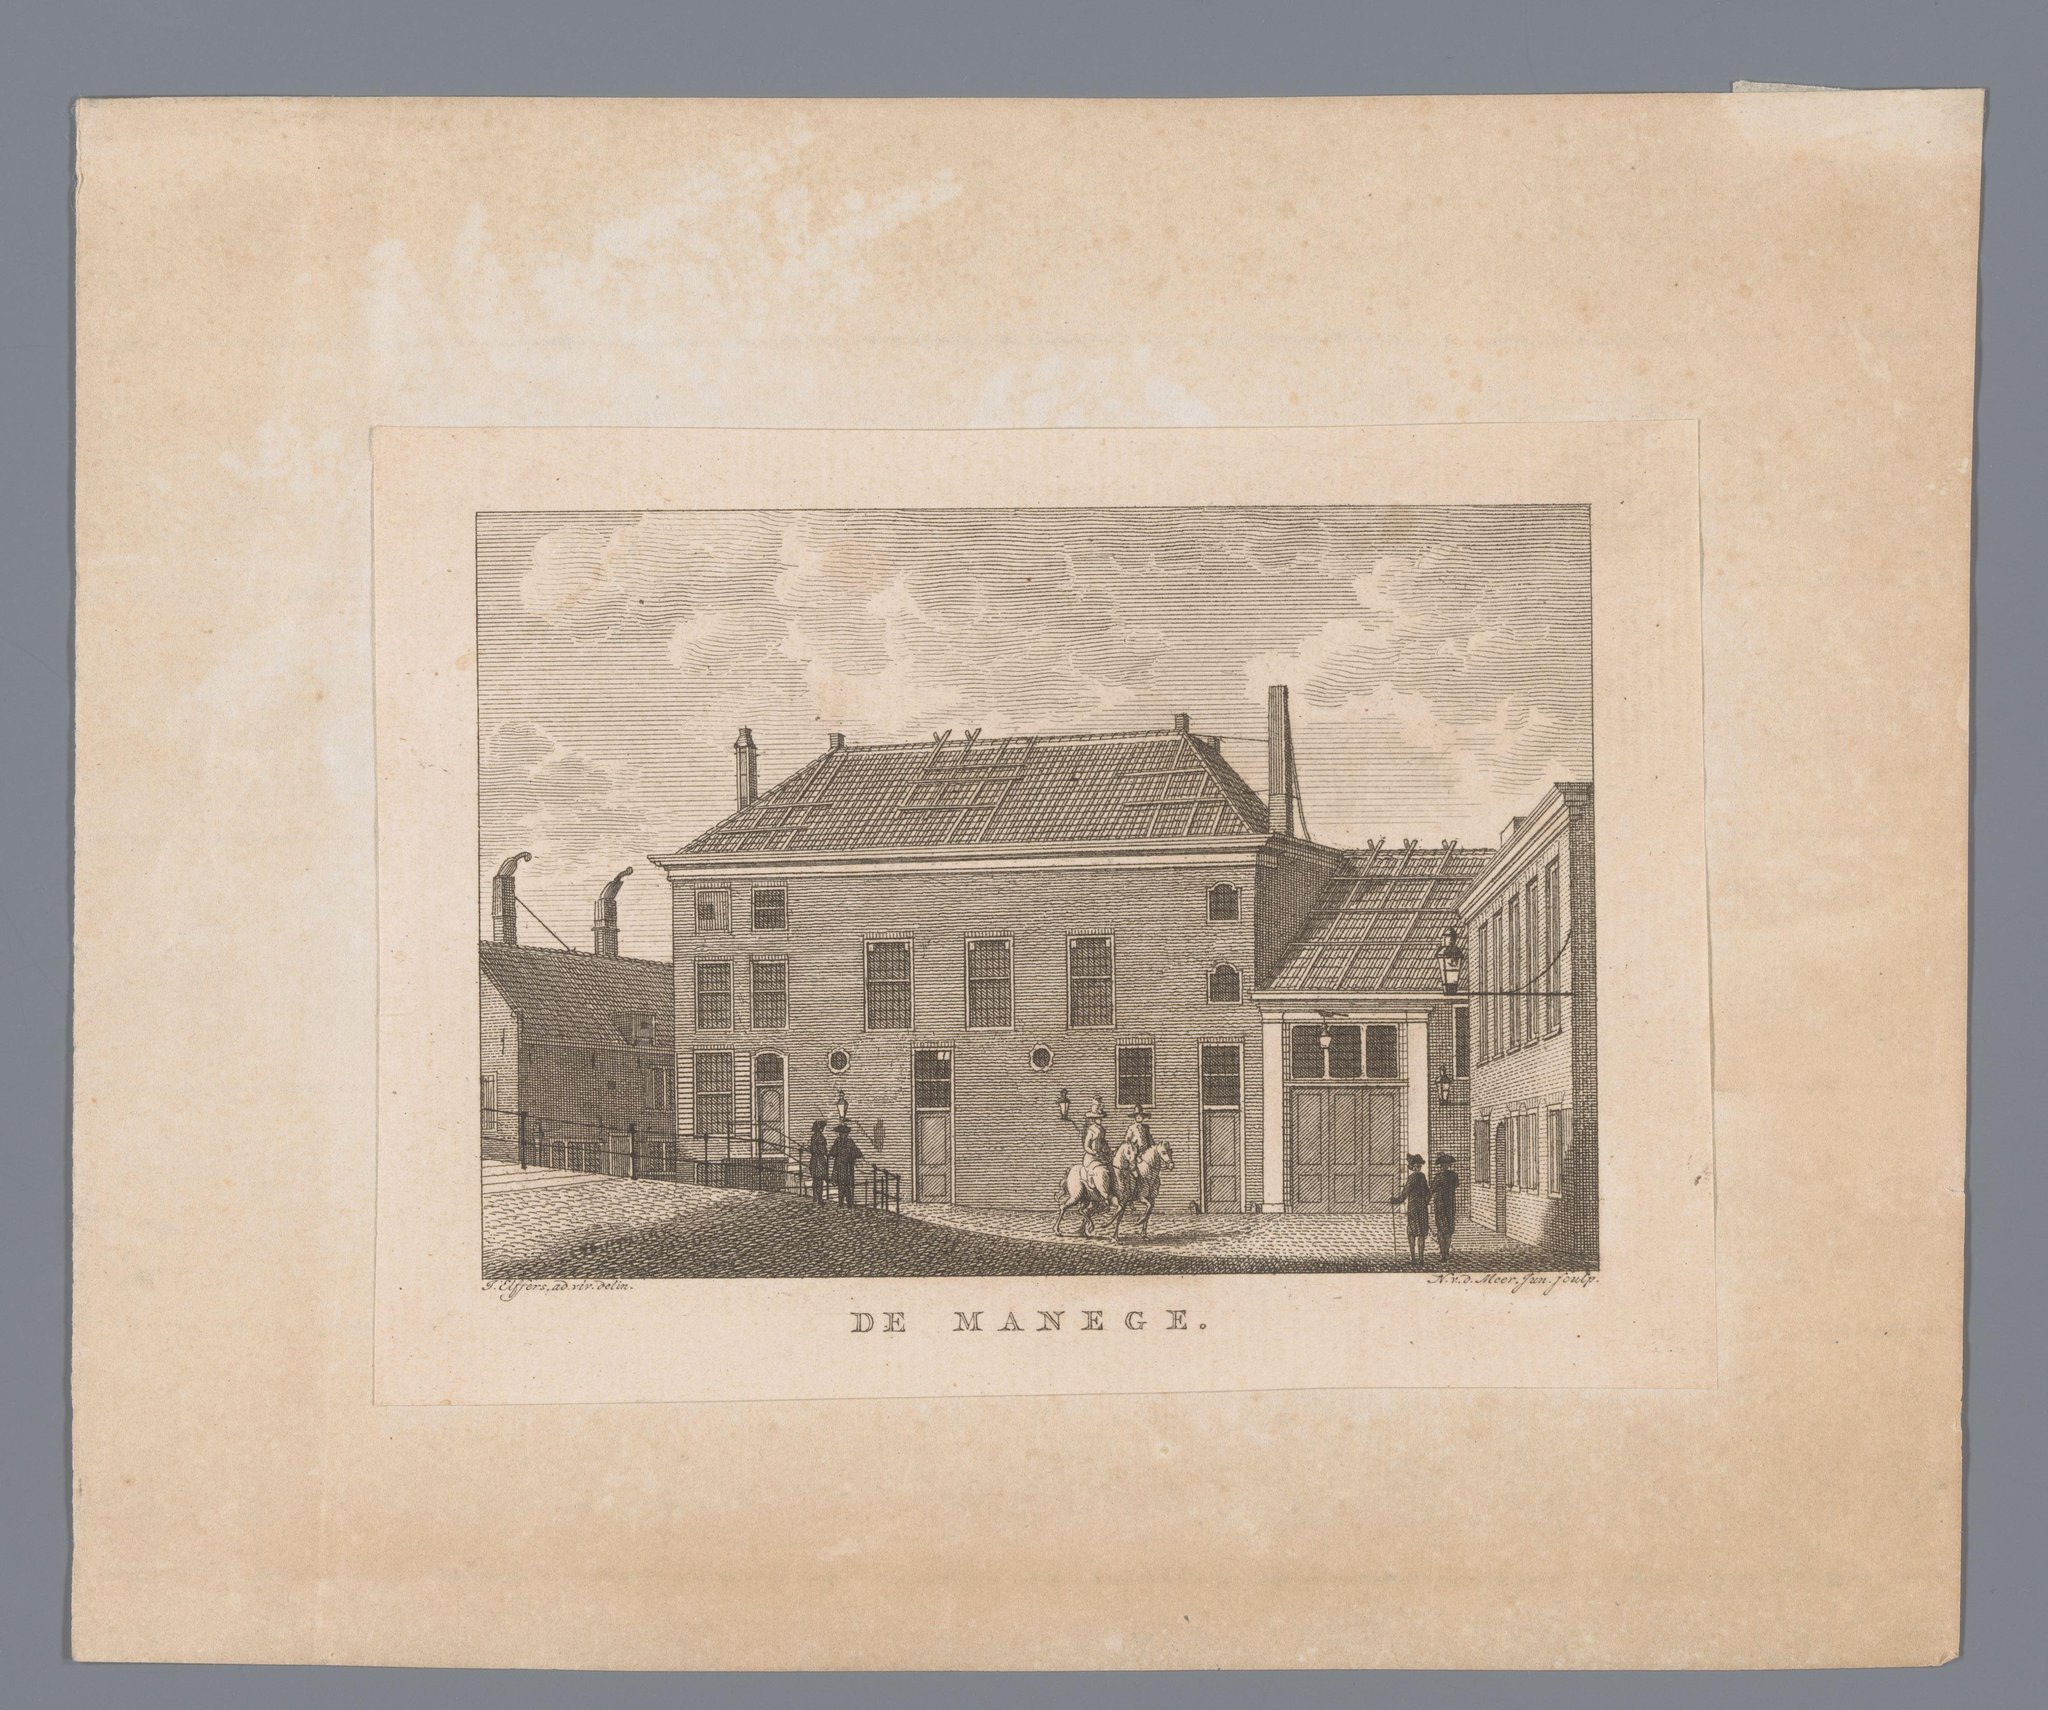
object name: book illustration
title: Voorgevel van de Hollandsche Manege in Amsterdam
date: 1790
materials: paper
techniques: etching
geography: amsterdam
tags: riding-school, manège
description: Uit: Fokke, Jan. Amsteldam en zyne geschiedenissen, in 't kort. 6 dln. Amsterdam: Johannes Allart, 1788-1792, dl. 4, na p. 52.